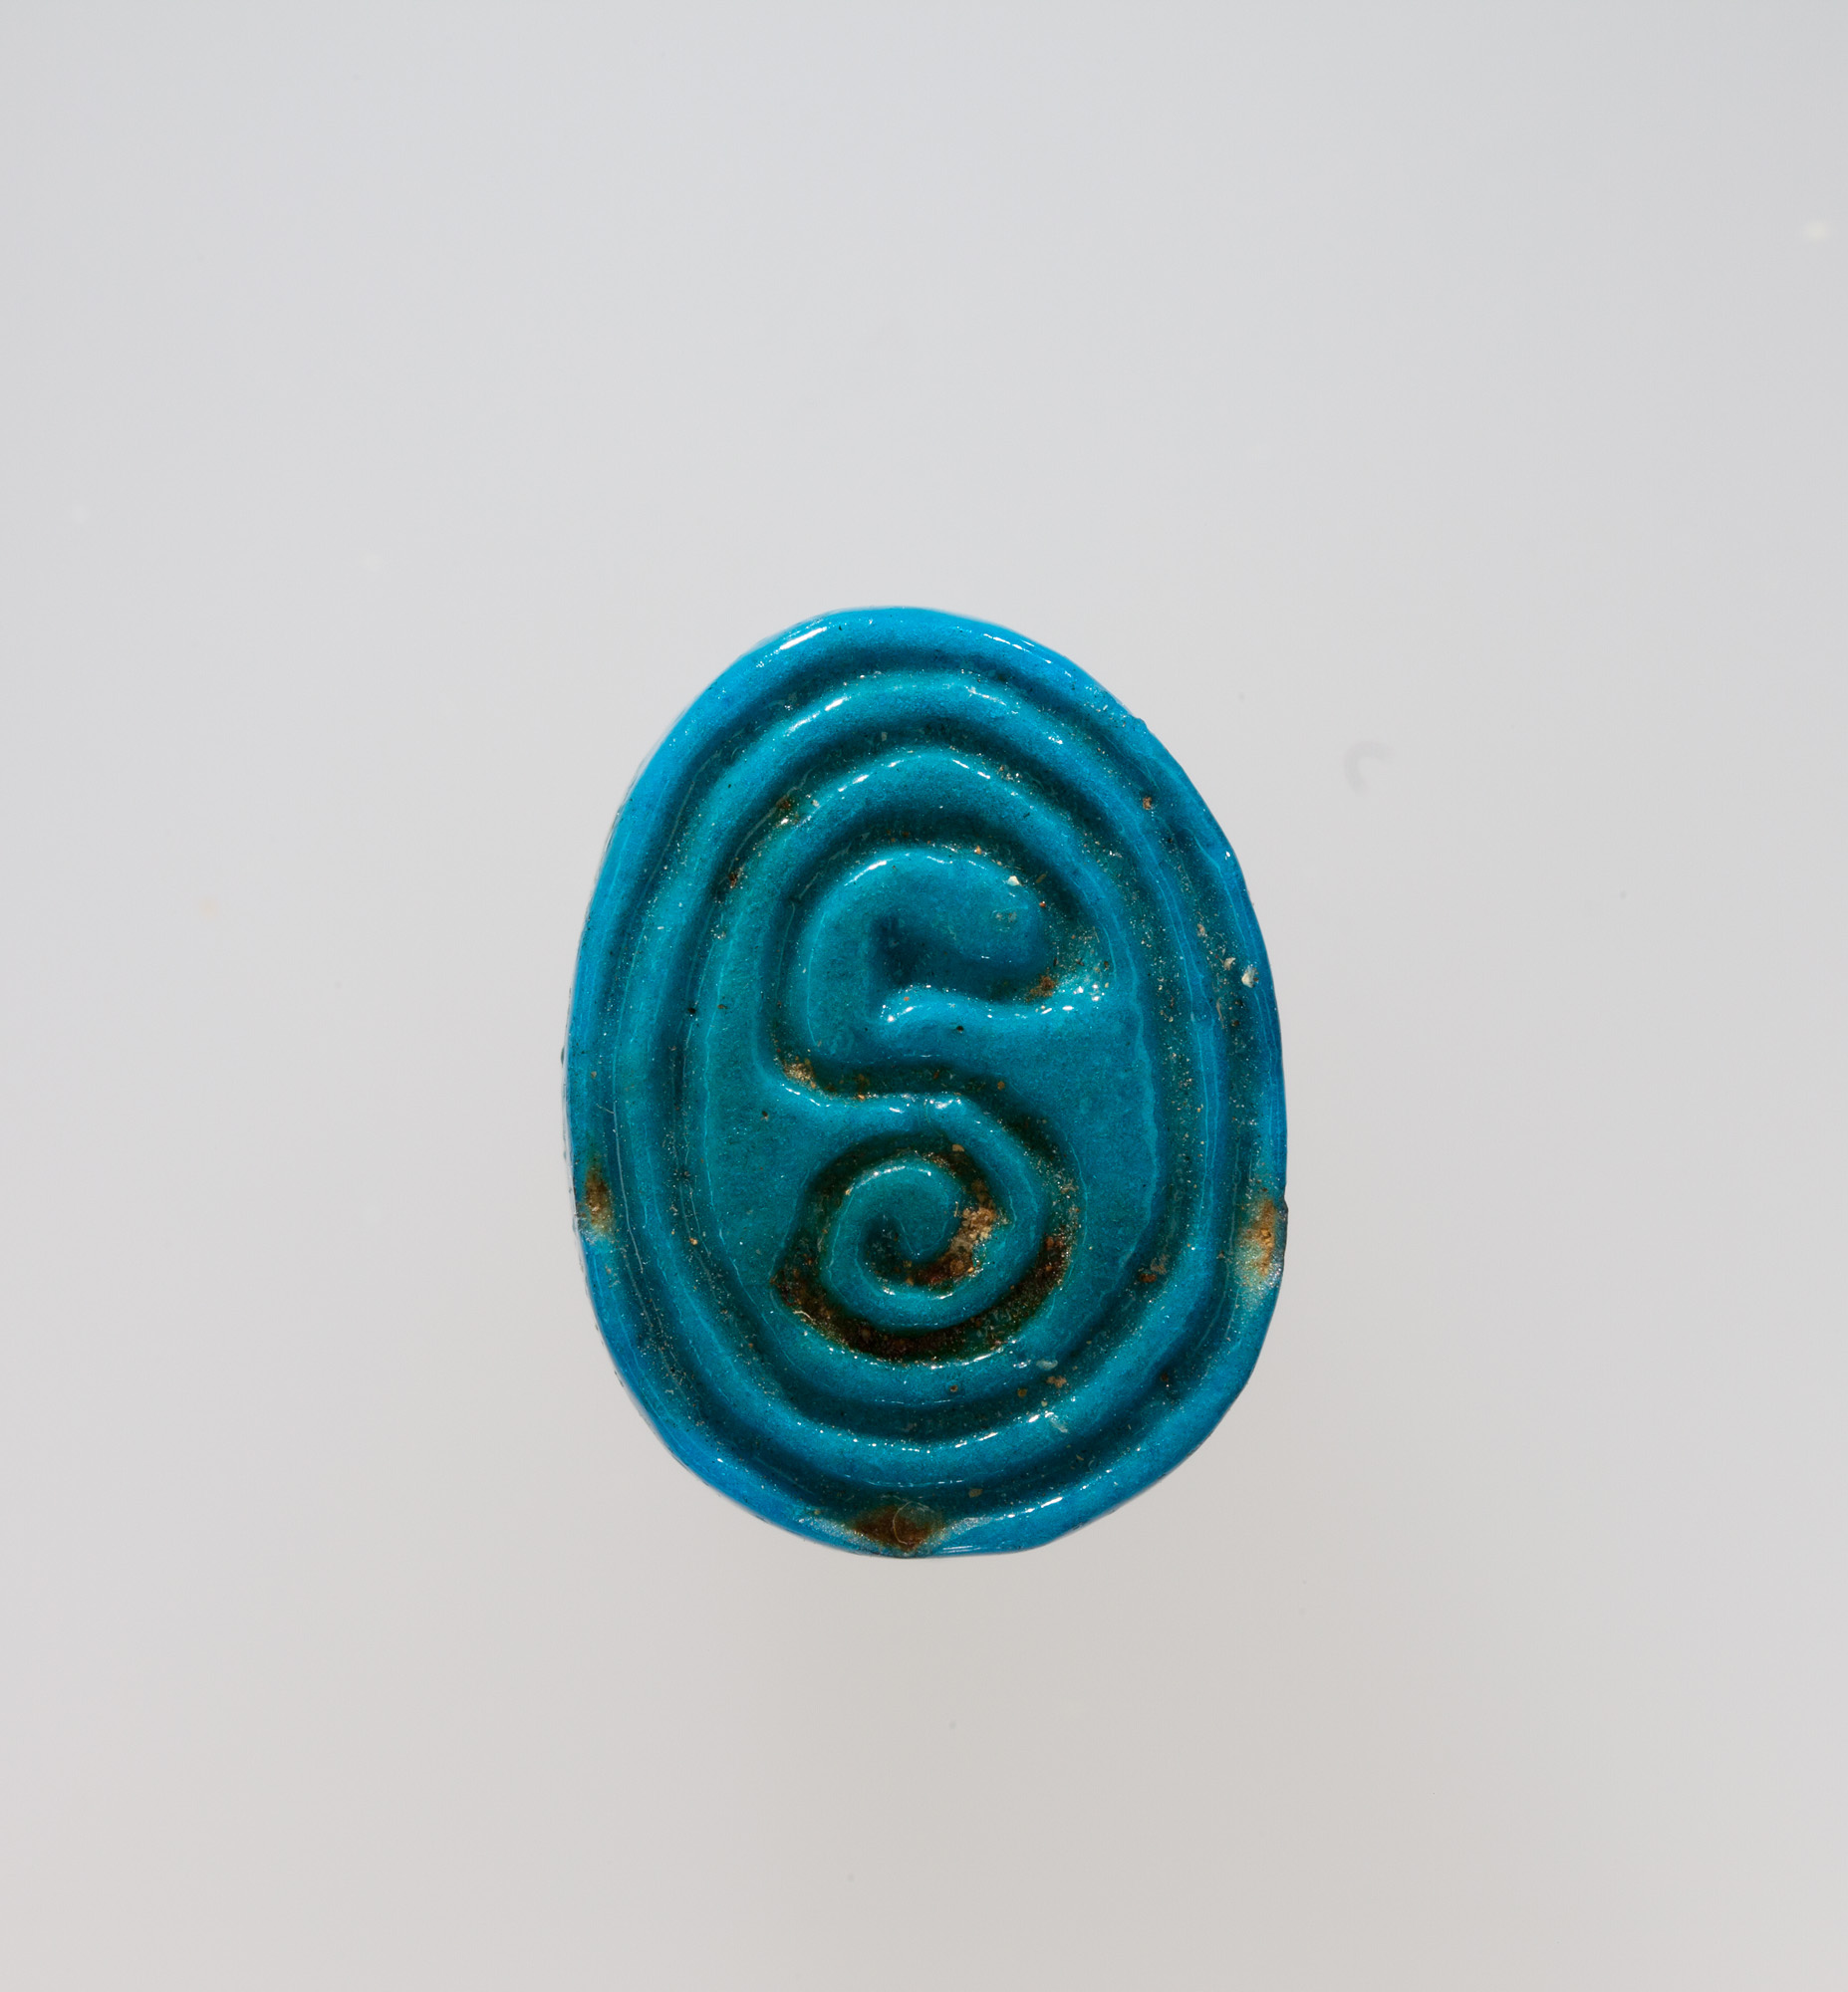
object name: scarab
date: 1479-1458 BCE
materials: faience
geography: egypt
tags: scarabs